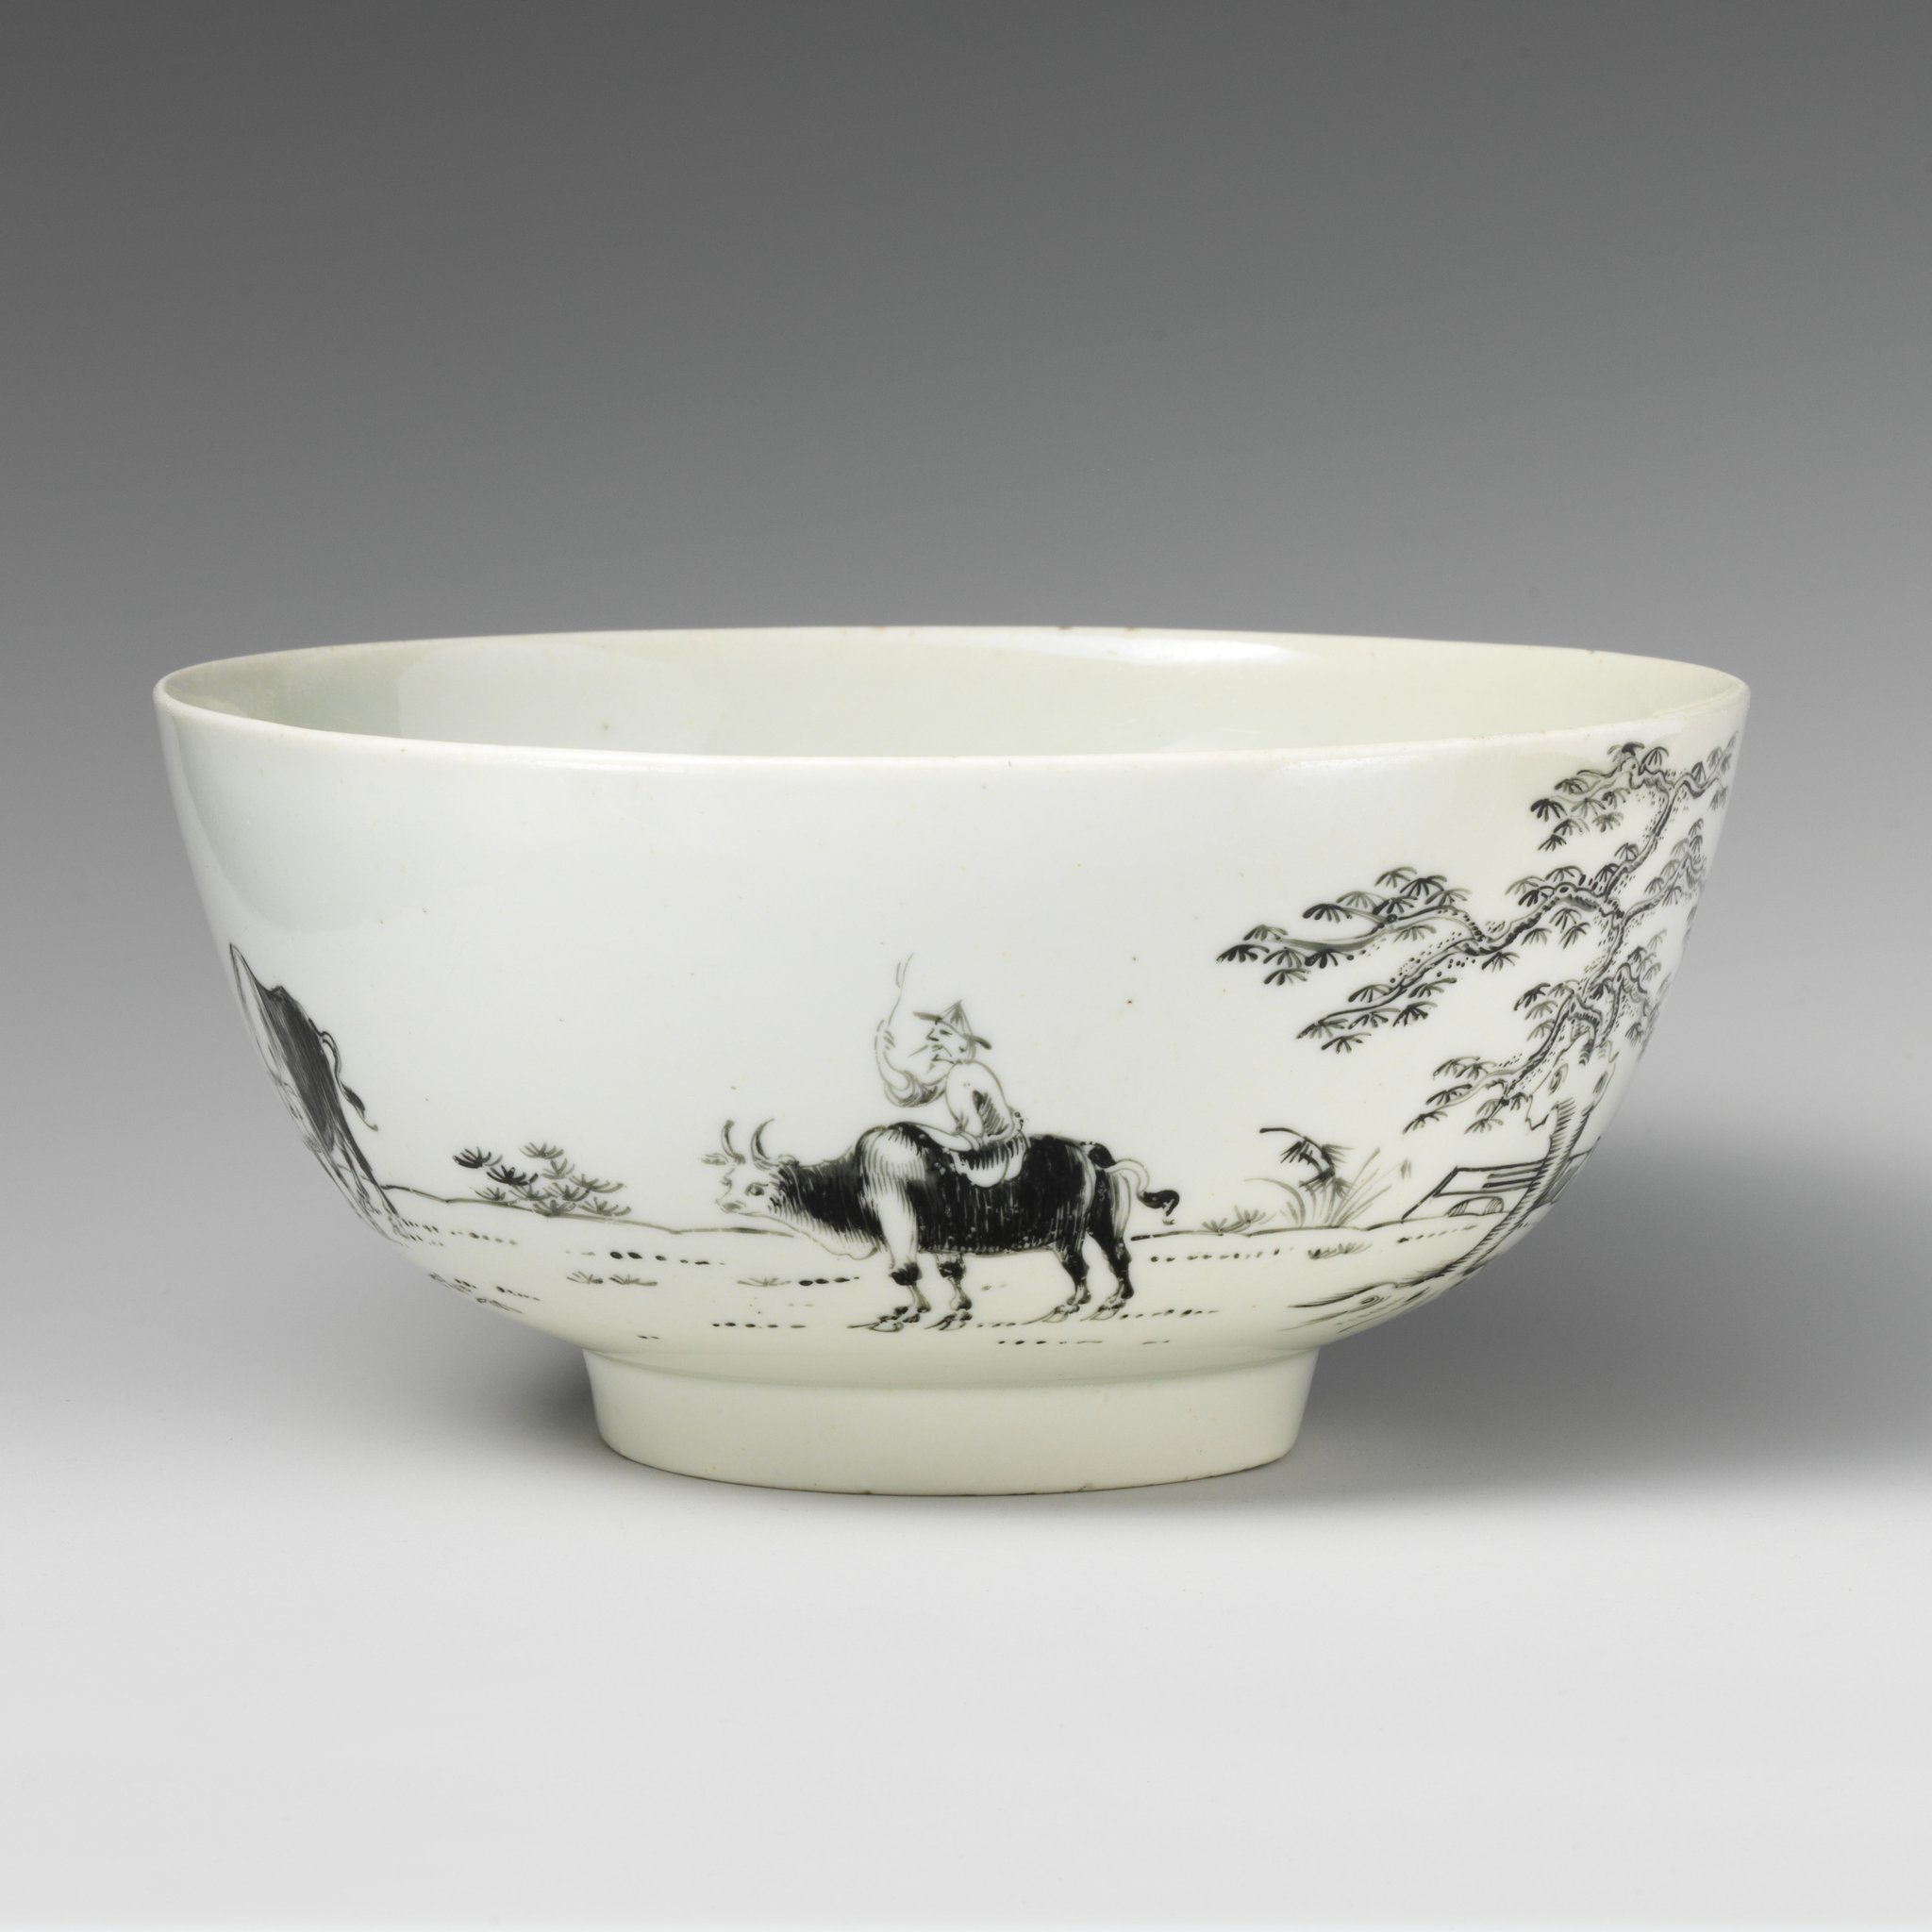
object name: bowl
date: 1701-1800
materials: soft paste porcelain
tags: men,bulls,trees